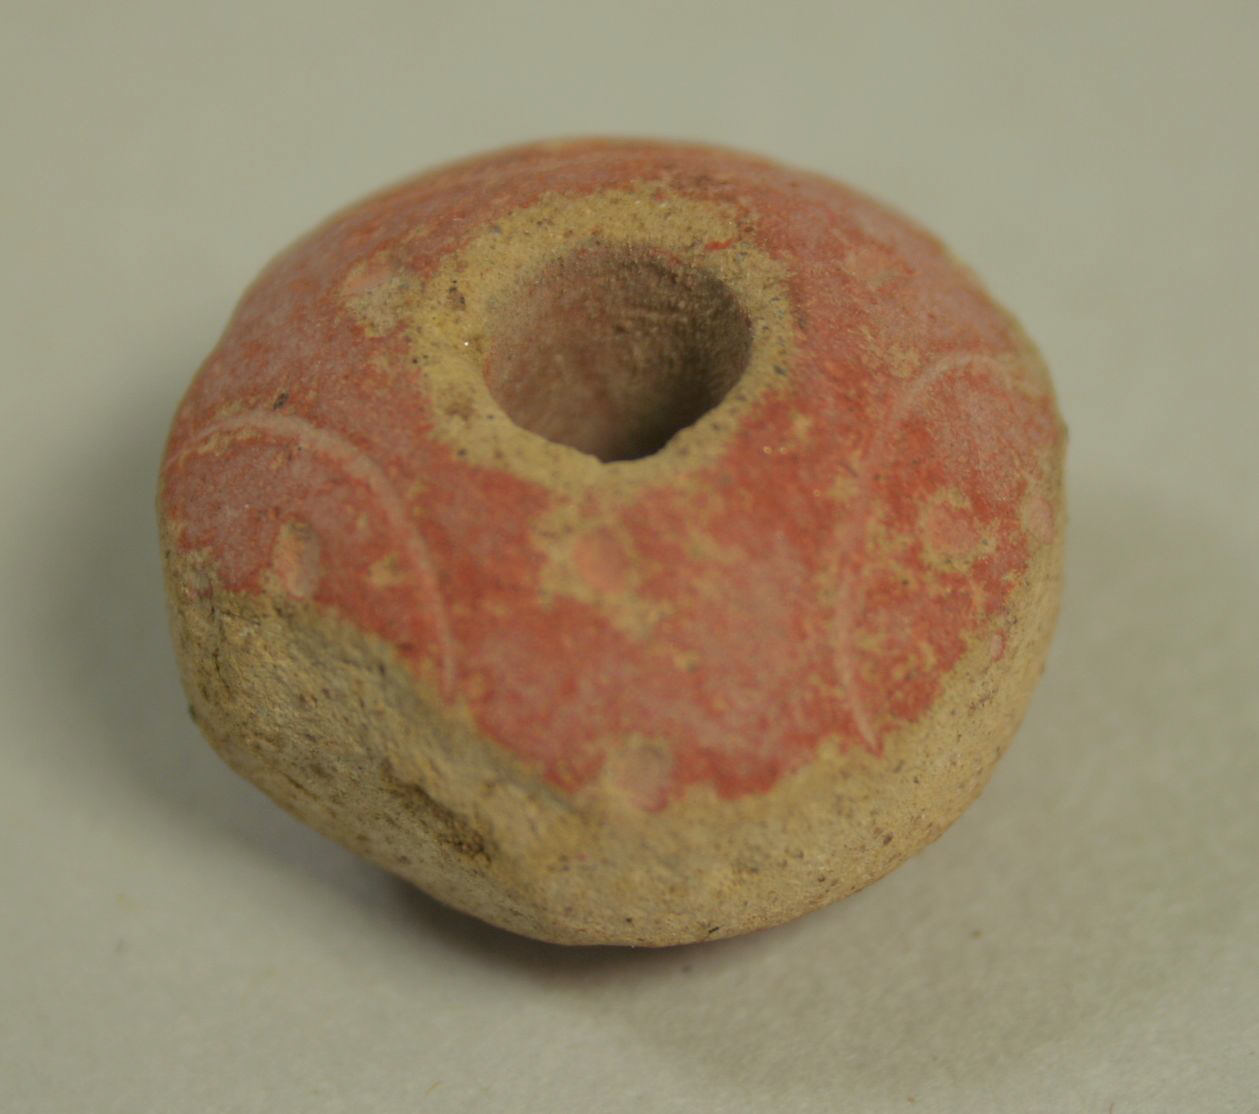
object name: spindle whorl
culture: peruvian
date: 901-1600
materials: ceramic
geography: peru